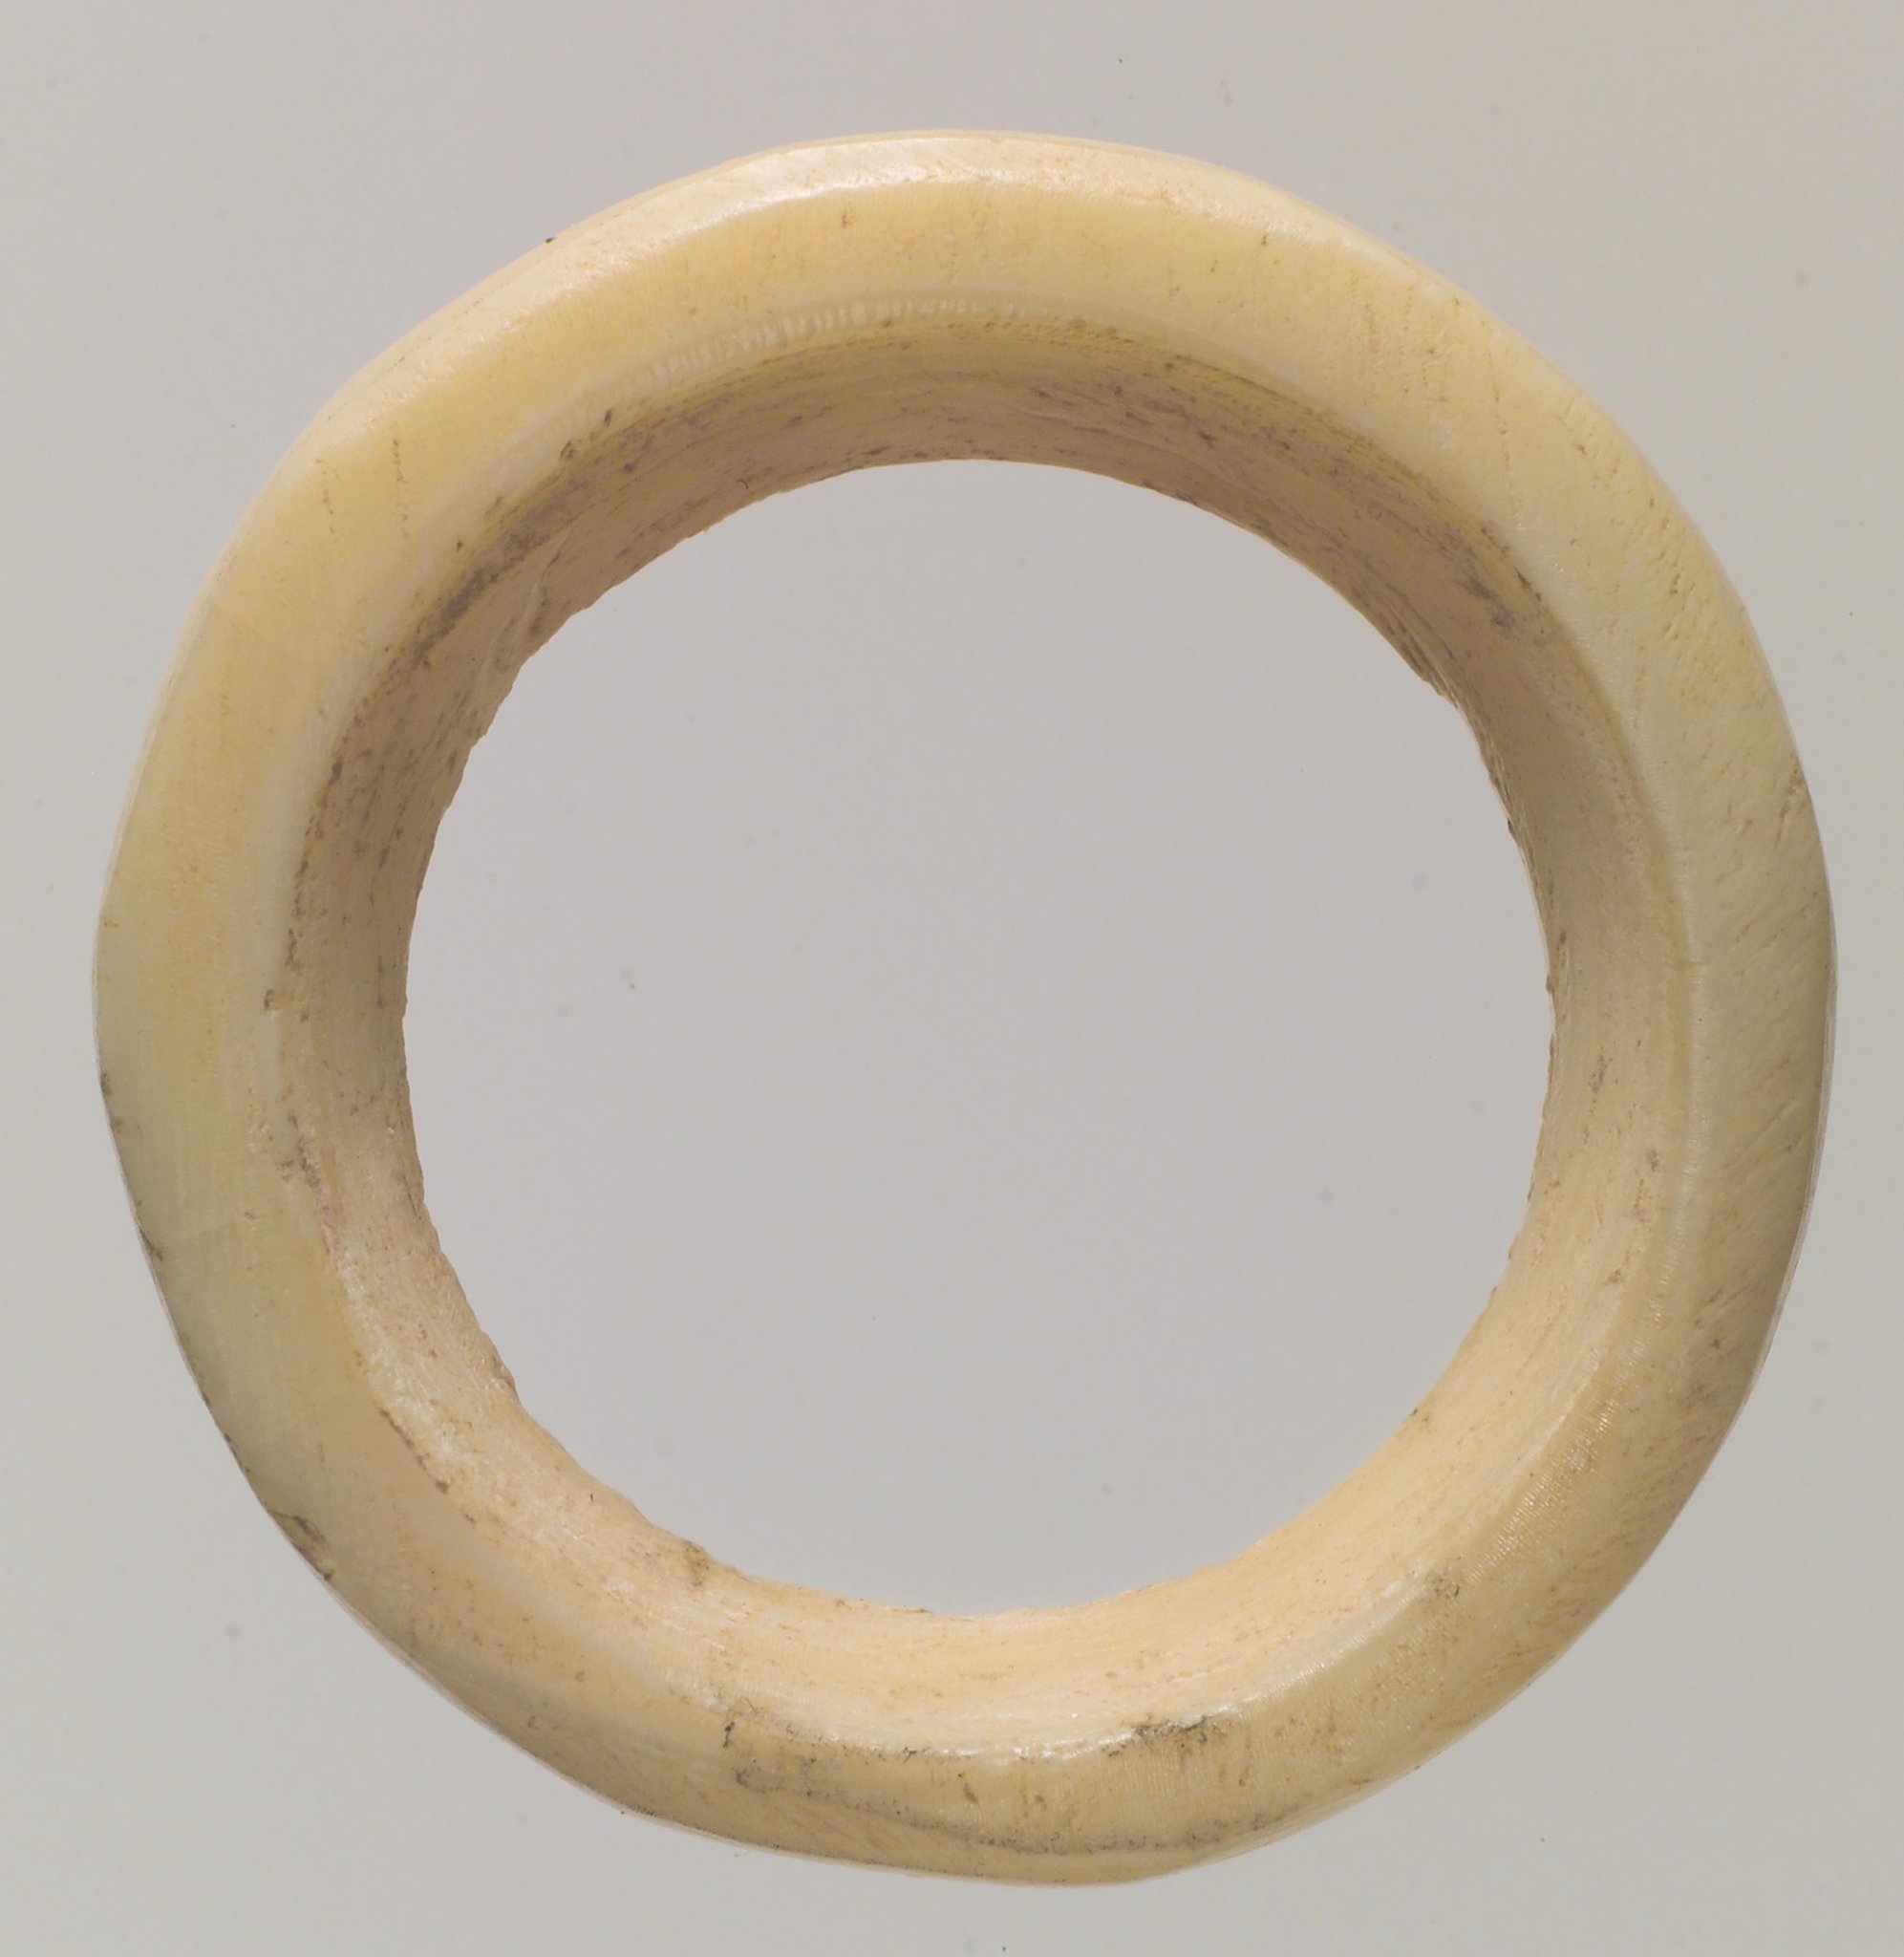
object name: ring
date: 3000-1001 BCE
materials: shell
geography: mesopotamia